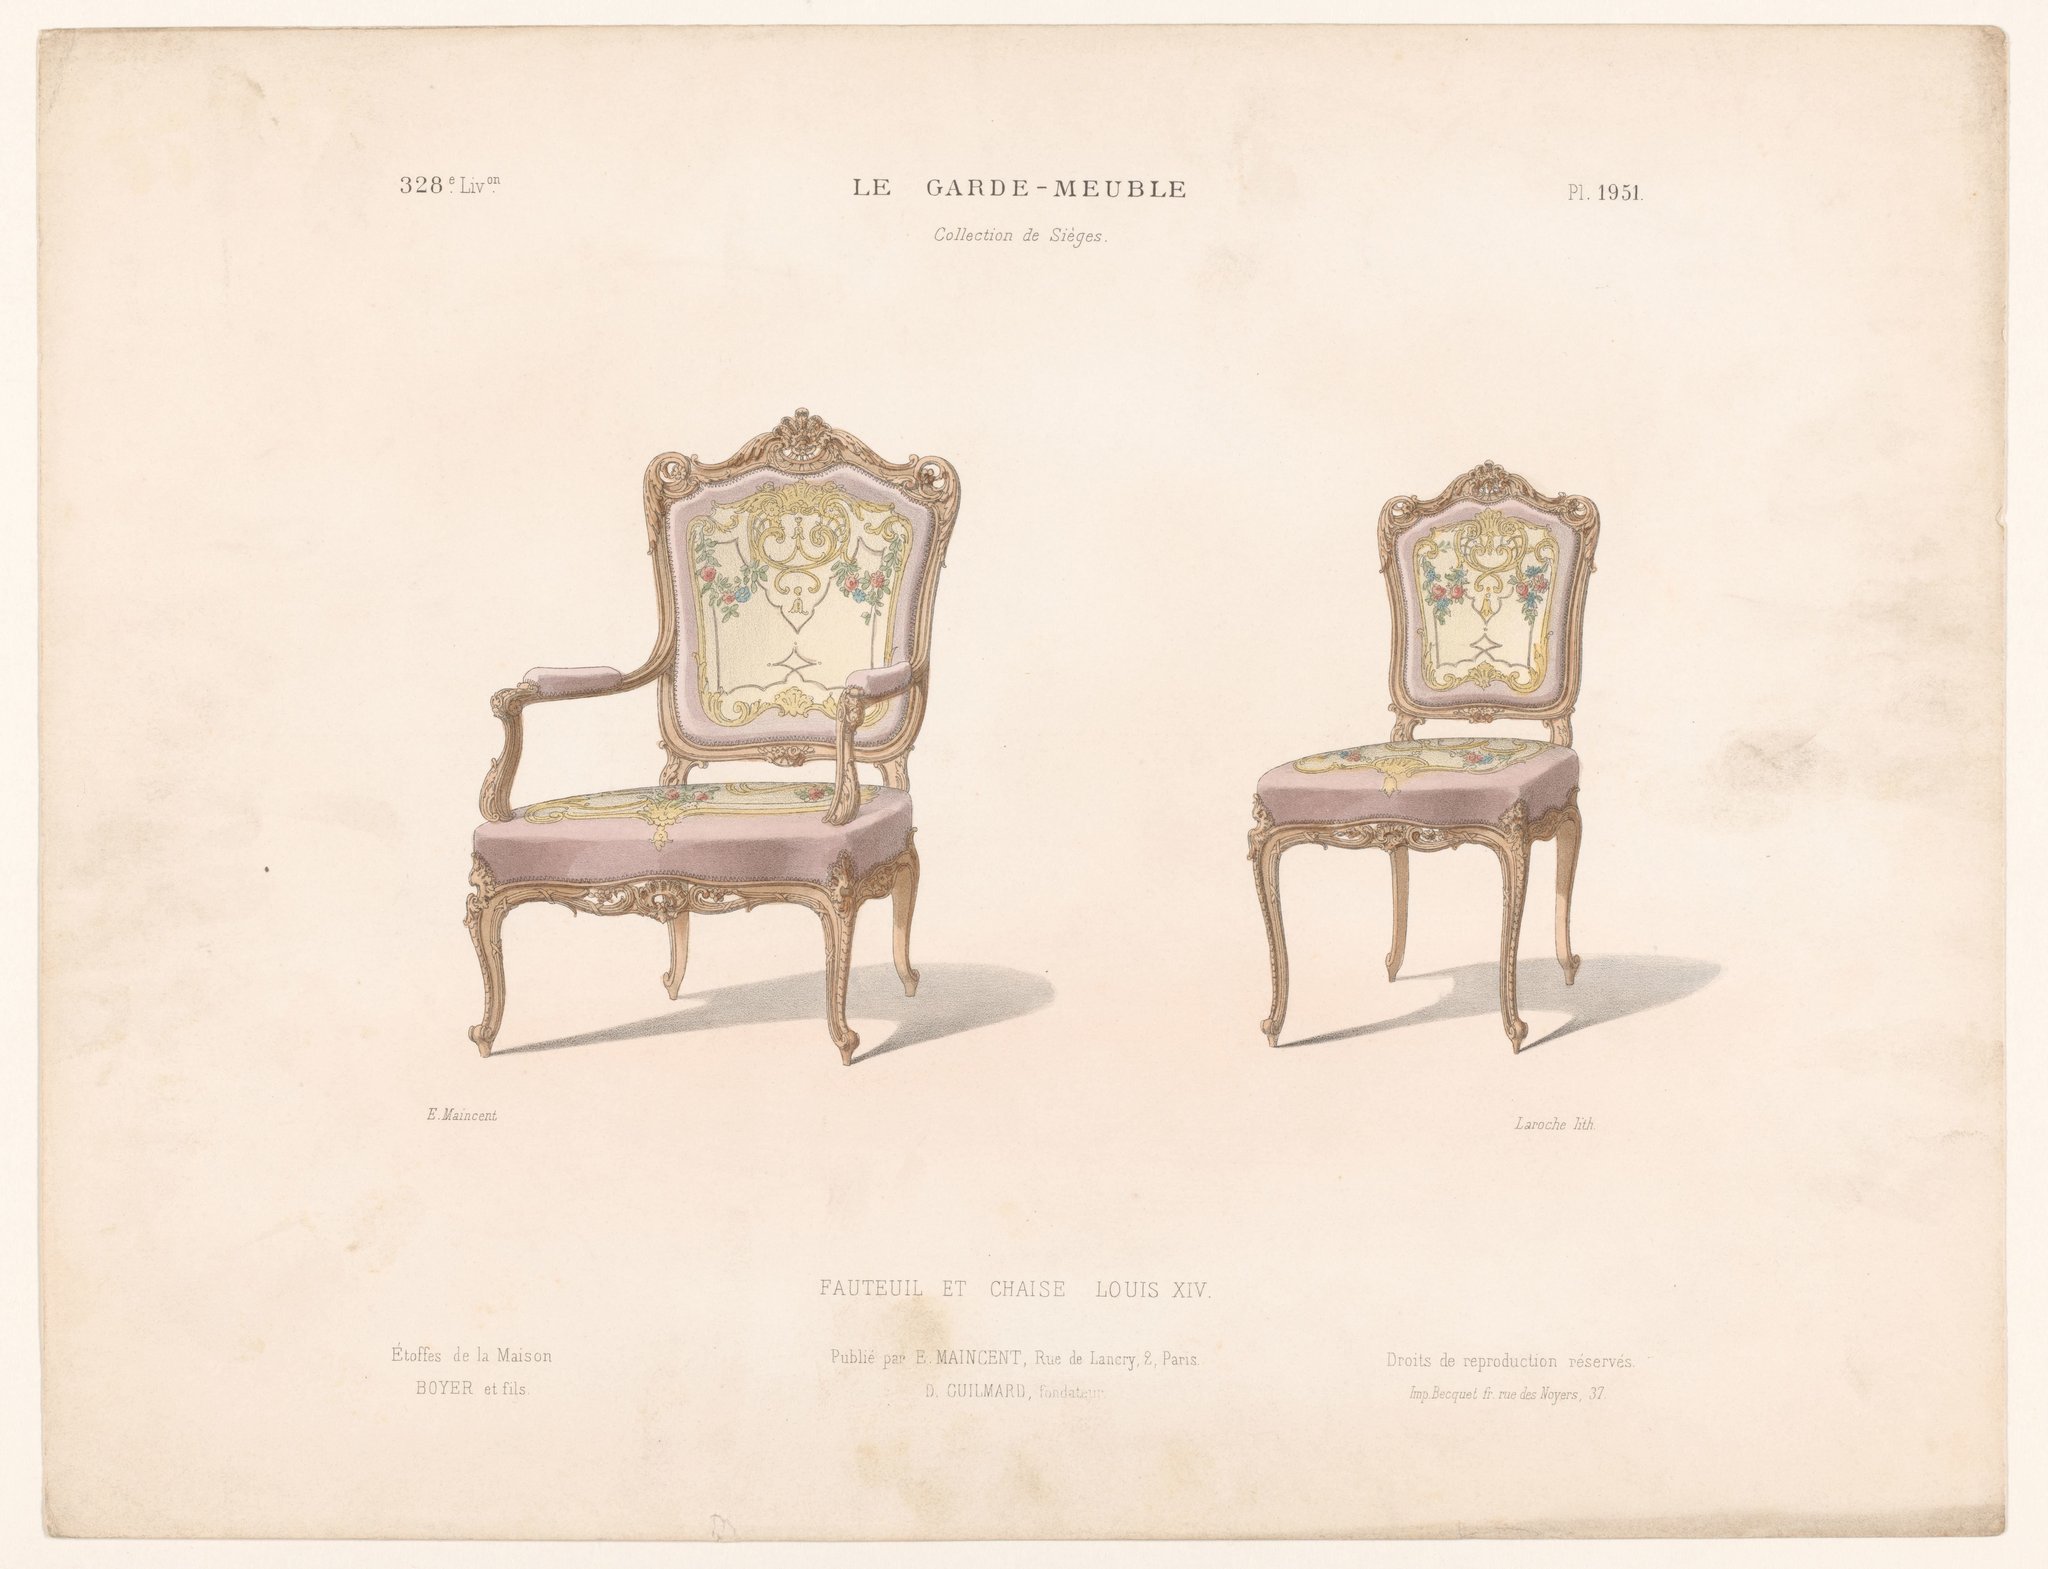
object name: print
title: Le garde-meuble / Collection de Sièges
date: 1885-1895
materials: paper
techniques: hand coloring, lithograph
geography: paris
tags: seating furniture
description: Ieder Livraison in de serie Le Garde-Meuble bevat negen platen: drie 'sièges' (zitmeubels), drie 'meubles' (diverse meubels zoals tafels en kasten) en drie 'tentures' (gordijnen en draperieën).